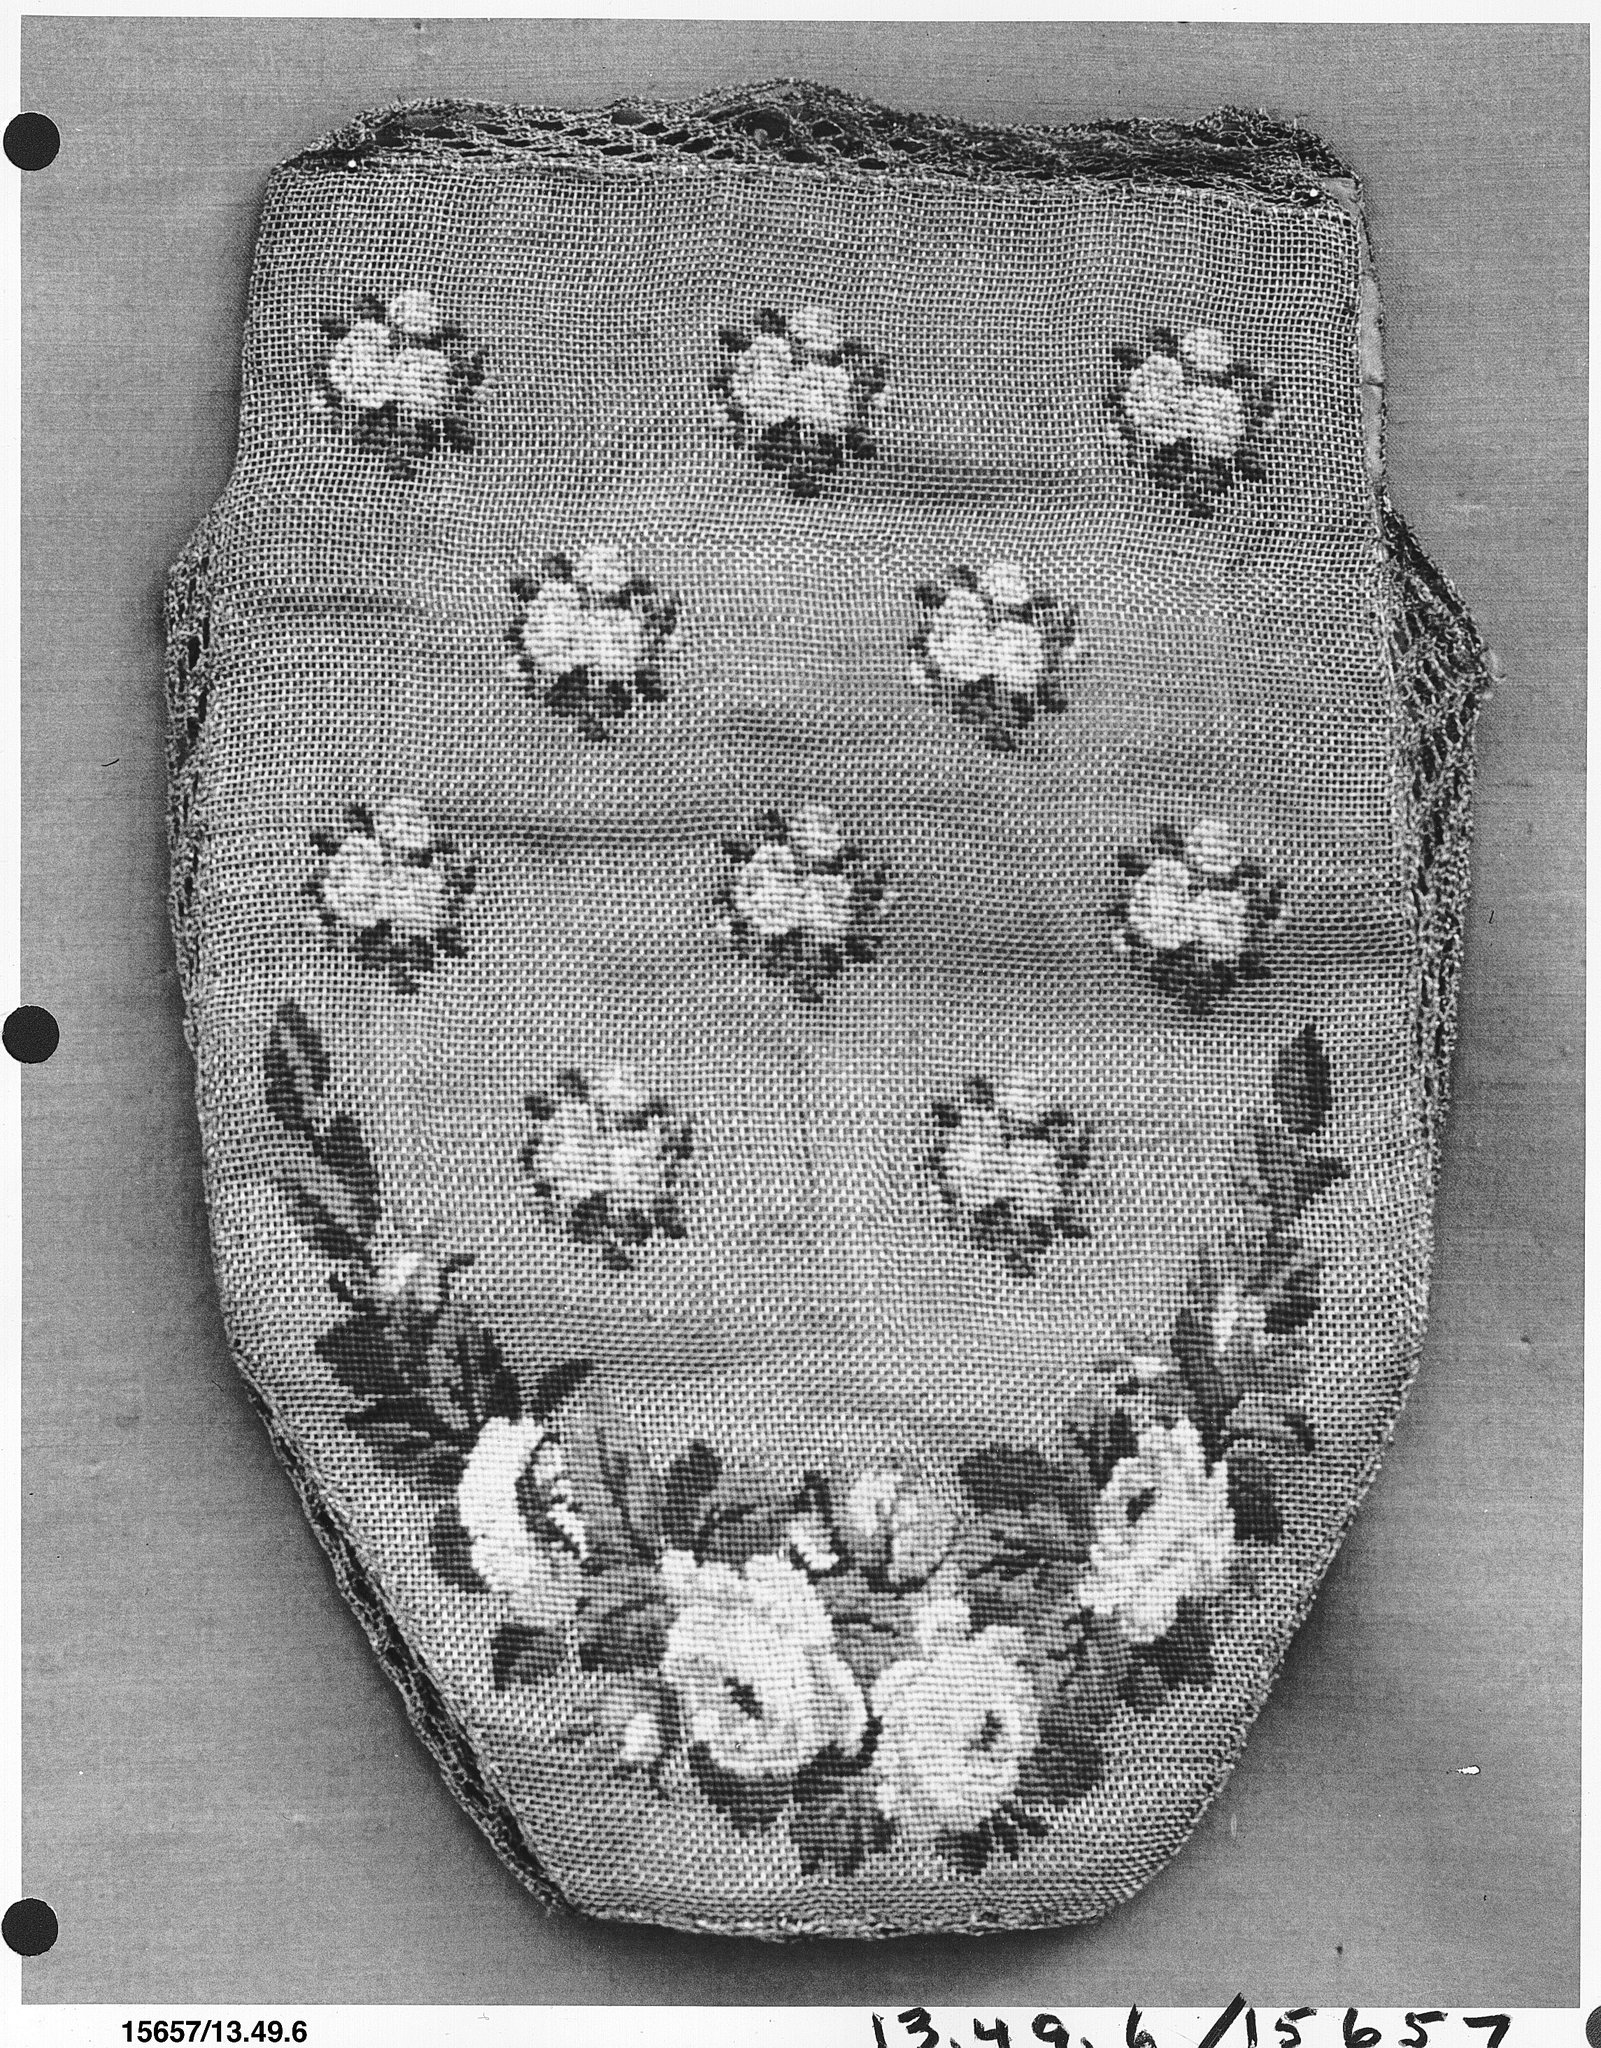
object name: reticule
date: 1767-1800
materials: canvas, gilt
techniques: embroidery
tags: flowers